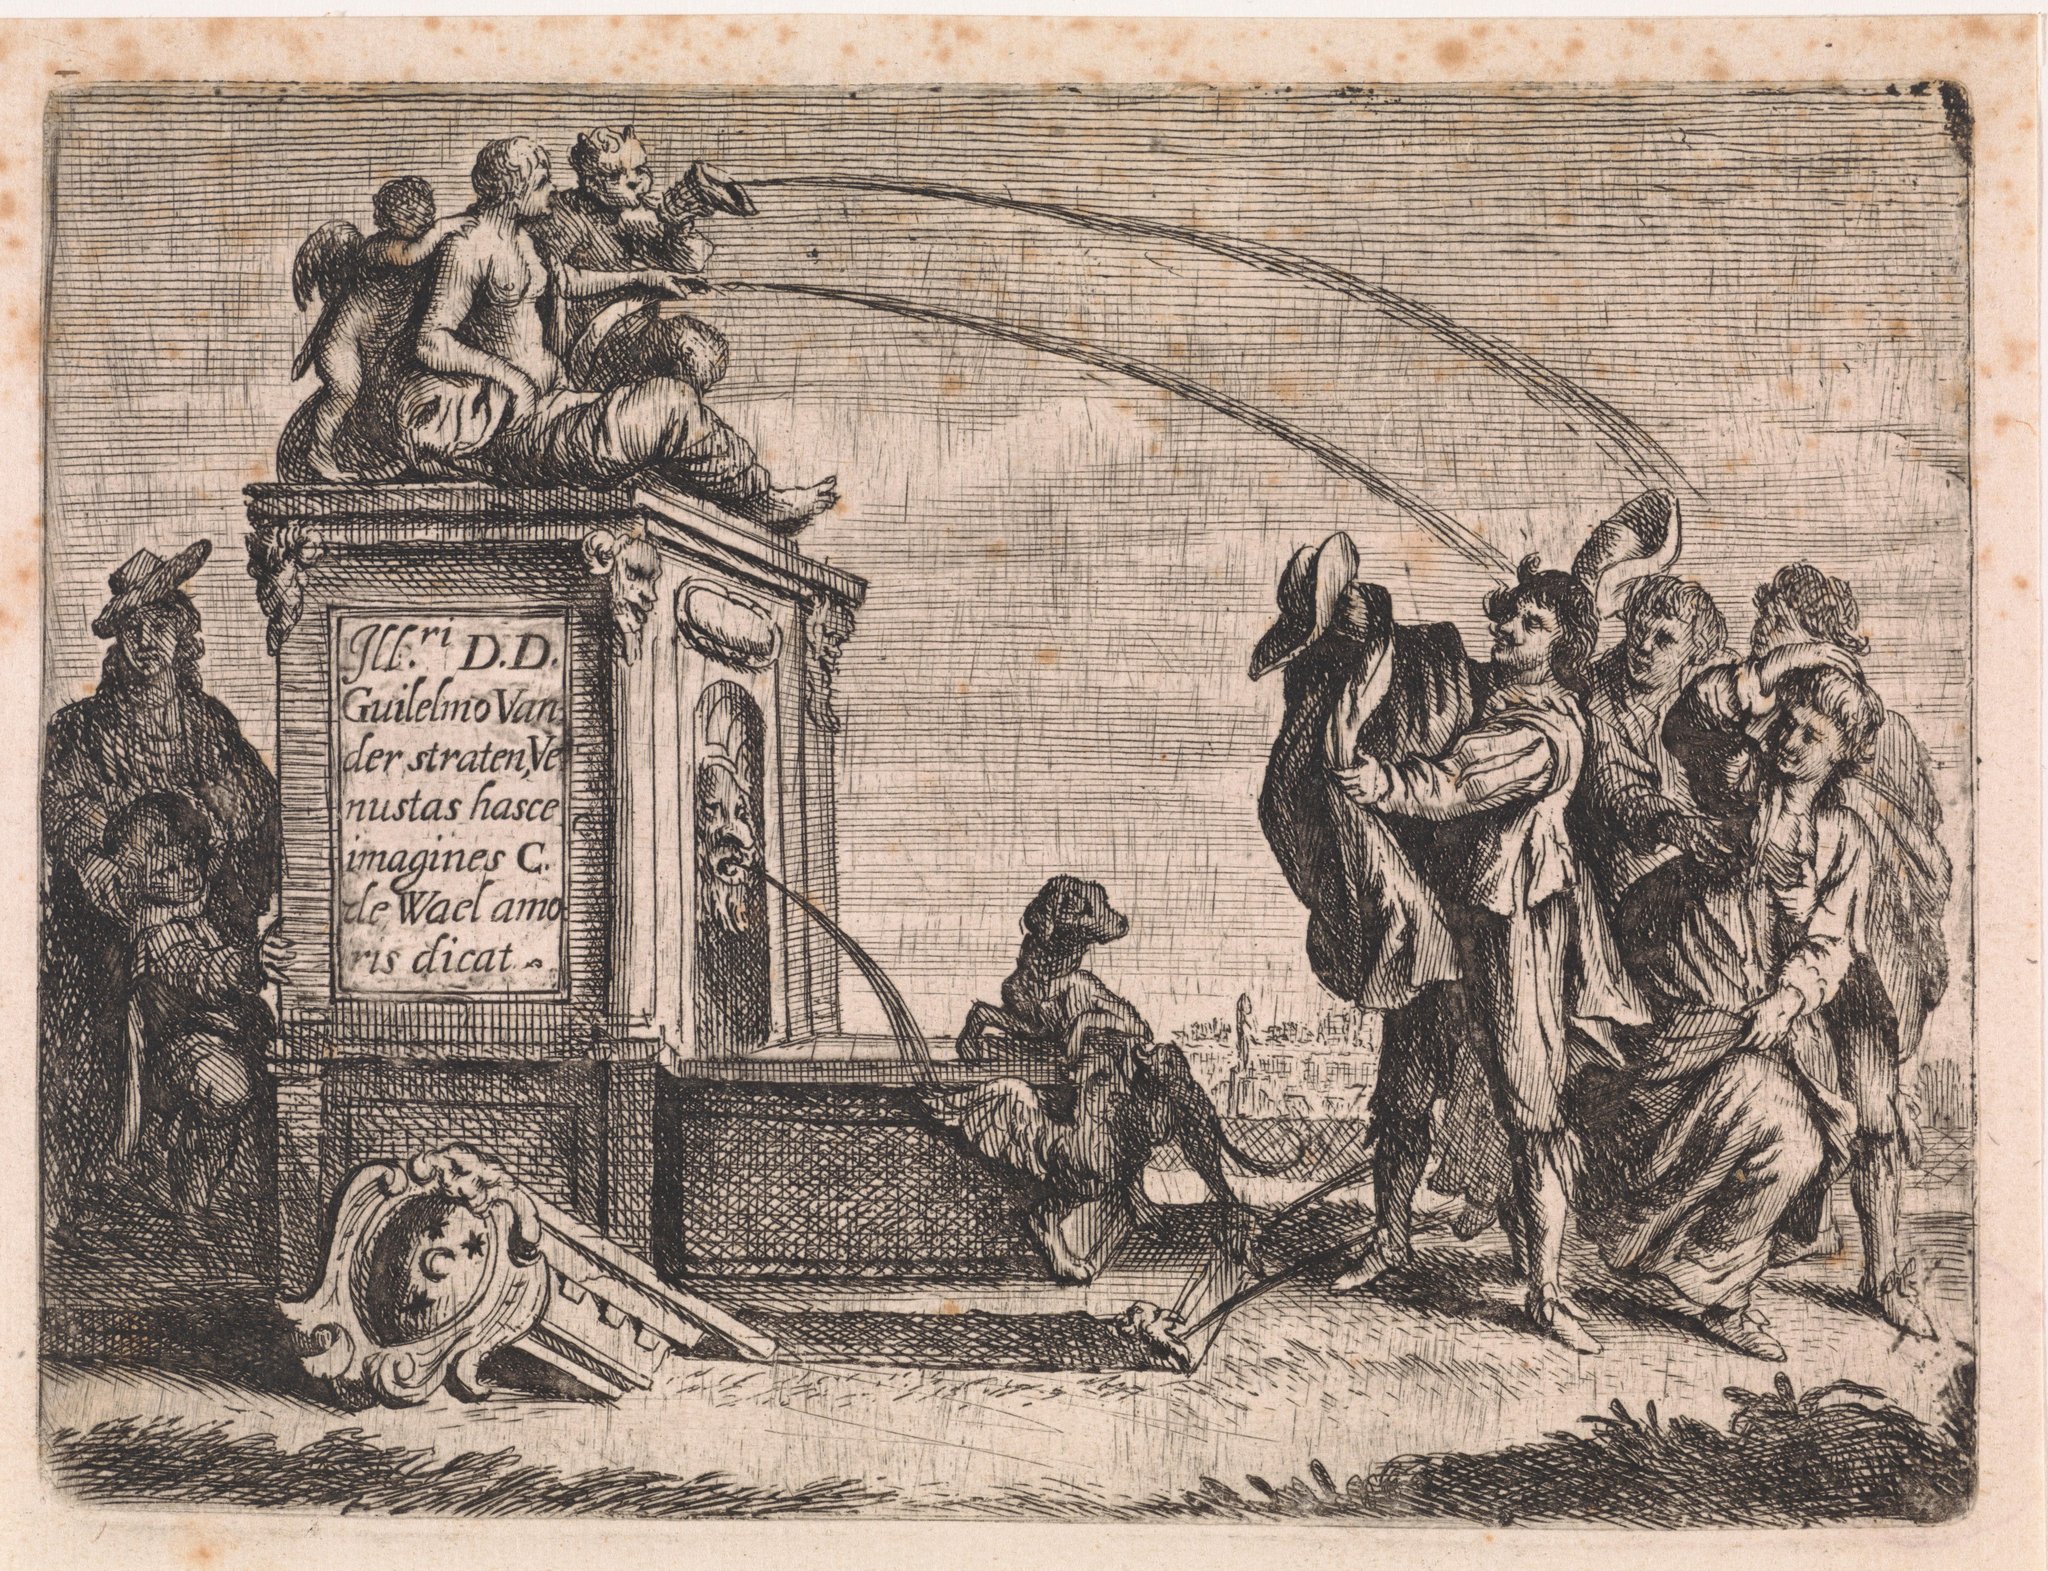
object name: print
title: Groep mensen bij fontein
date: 1633-1648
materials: paper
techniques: engraving, etching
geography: italy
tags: other architectural details (cornice), garden fountain, dog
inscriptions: collector's mark: Lugt 240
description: Een groep mannen en vrouwen bij een klassieke fontein probeert zich met hoeden en jassen te weren tegen het water dat eruit spuit. Op de voorgrond ligt een afgebroken kroonlijst met een wapenschild. Een man en kind kijken stiekem toe van achter de fontein. Op de zijkant van de fontein een opdracht in het Latijn.